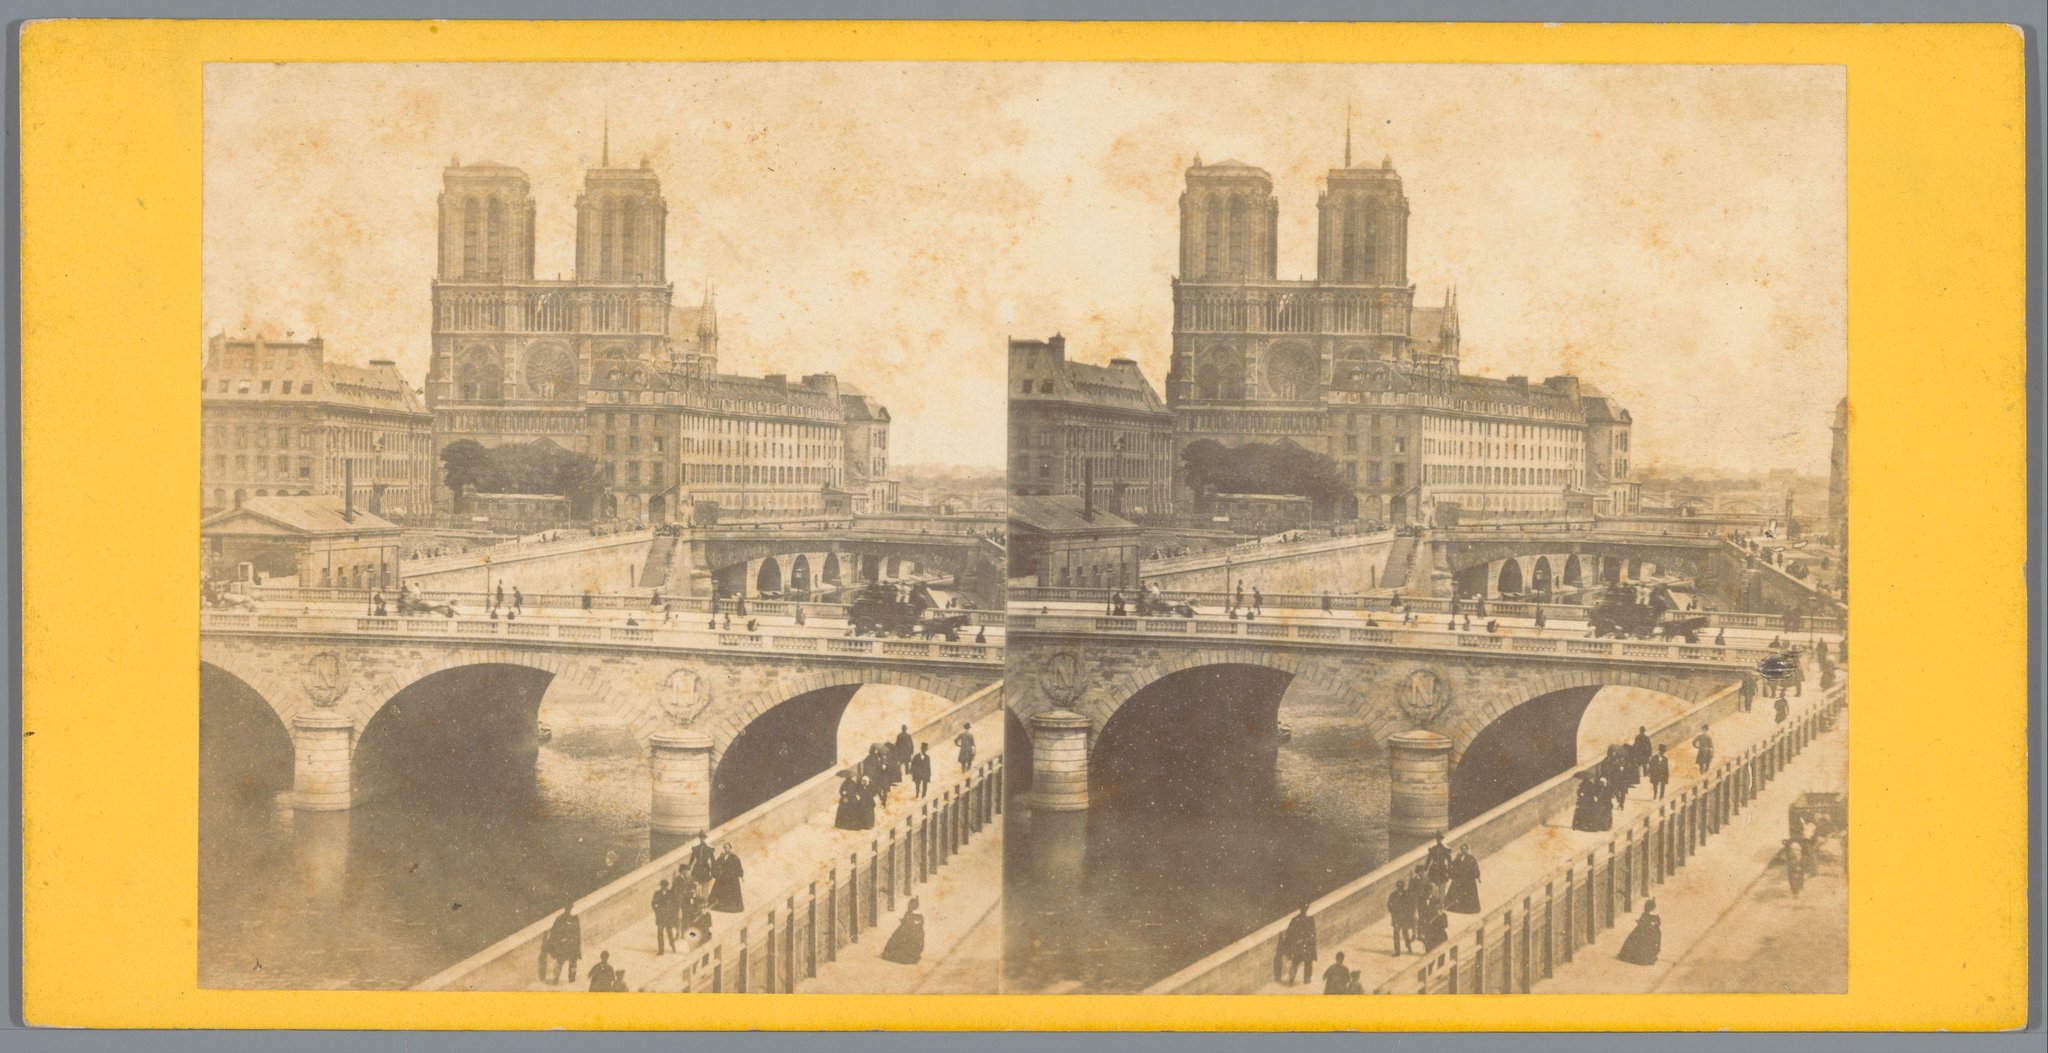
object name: stereograph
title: Gezicht op Pont Saint-Michel en de Notre-Dame in Parijs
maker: Anonymous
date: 1850-1868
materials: cardboard, photographic support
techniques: albumen print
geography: paris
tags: church (exterior), bridge in city across river, canal, etc.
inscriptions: inscription: ‘Notre Dame Aug-Sept. 68 LH Kuhn [...]’